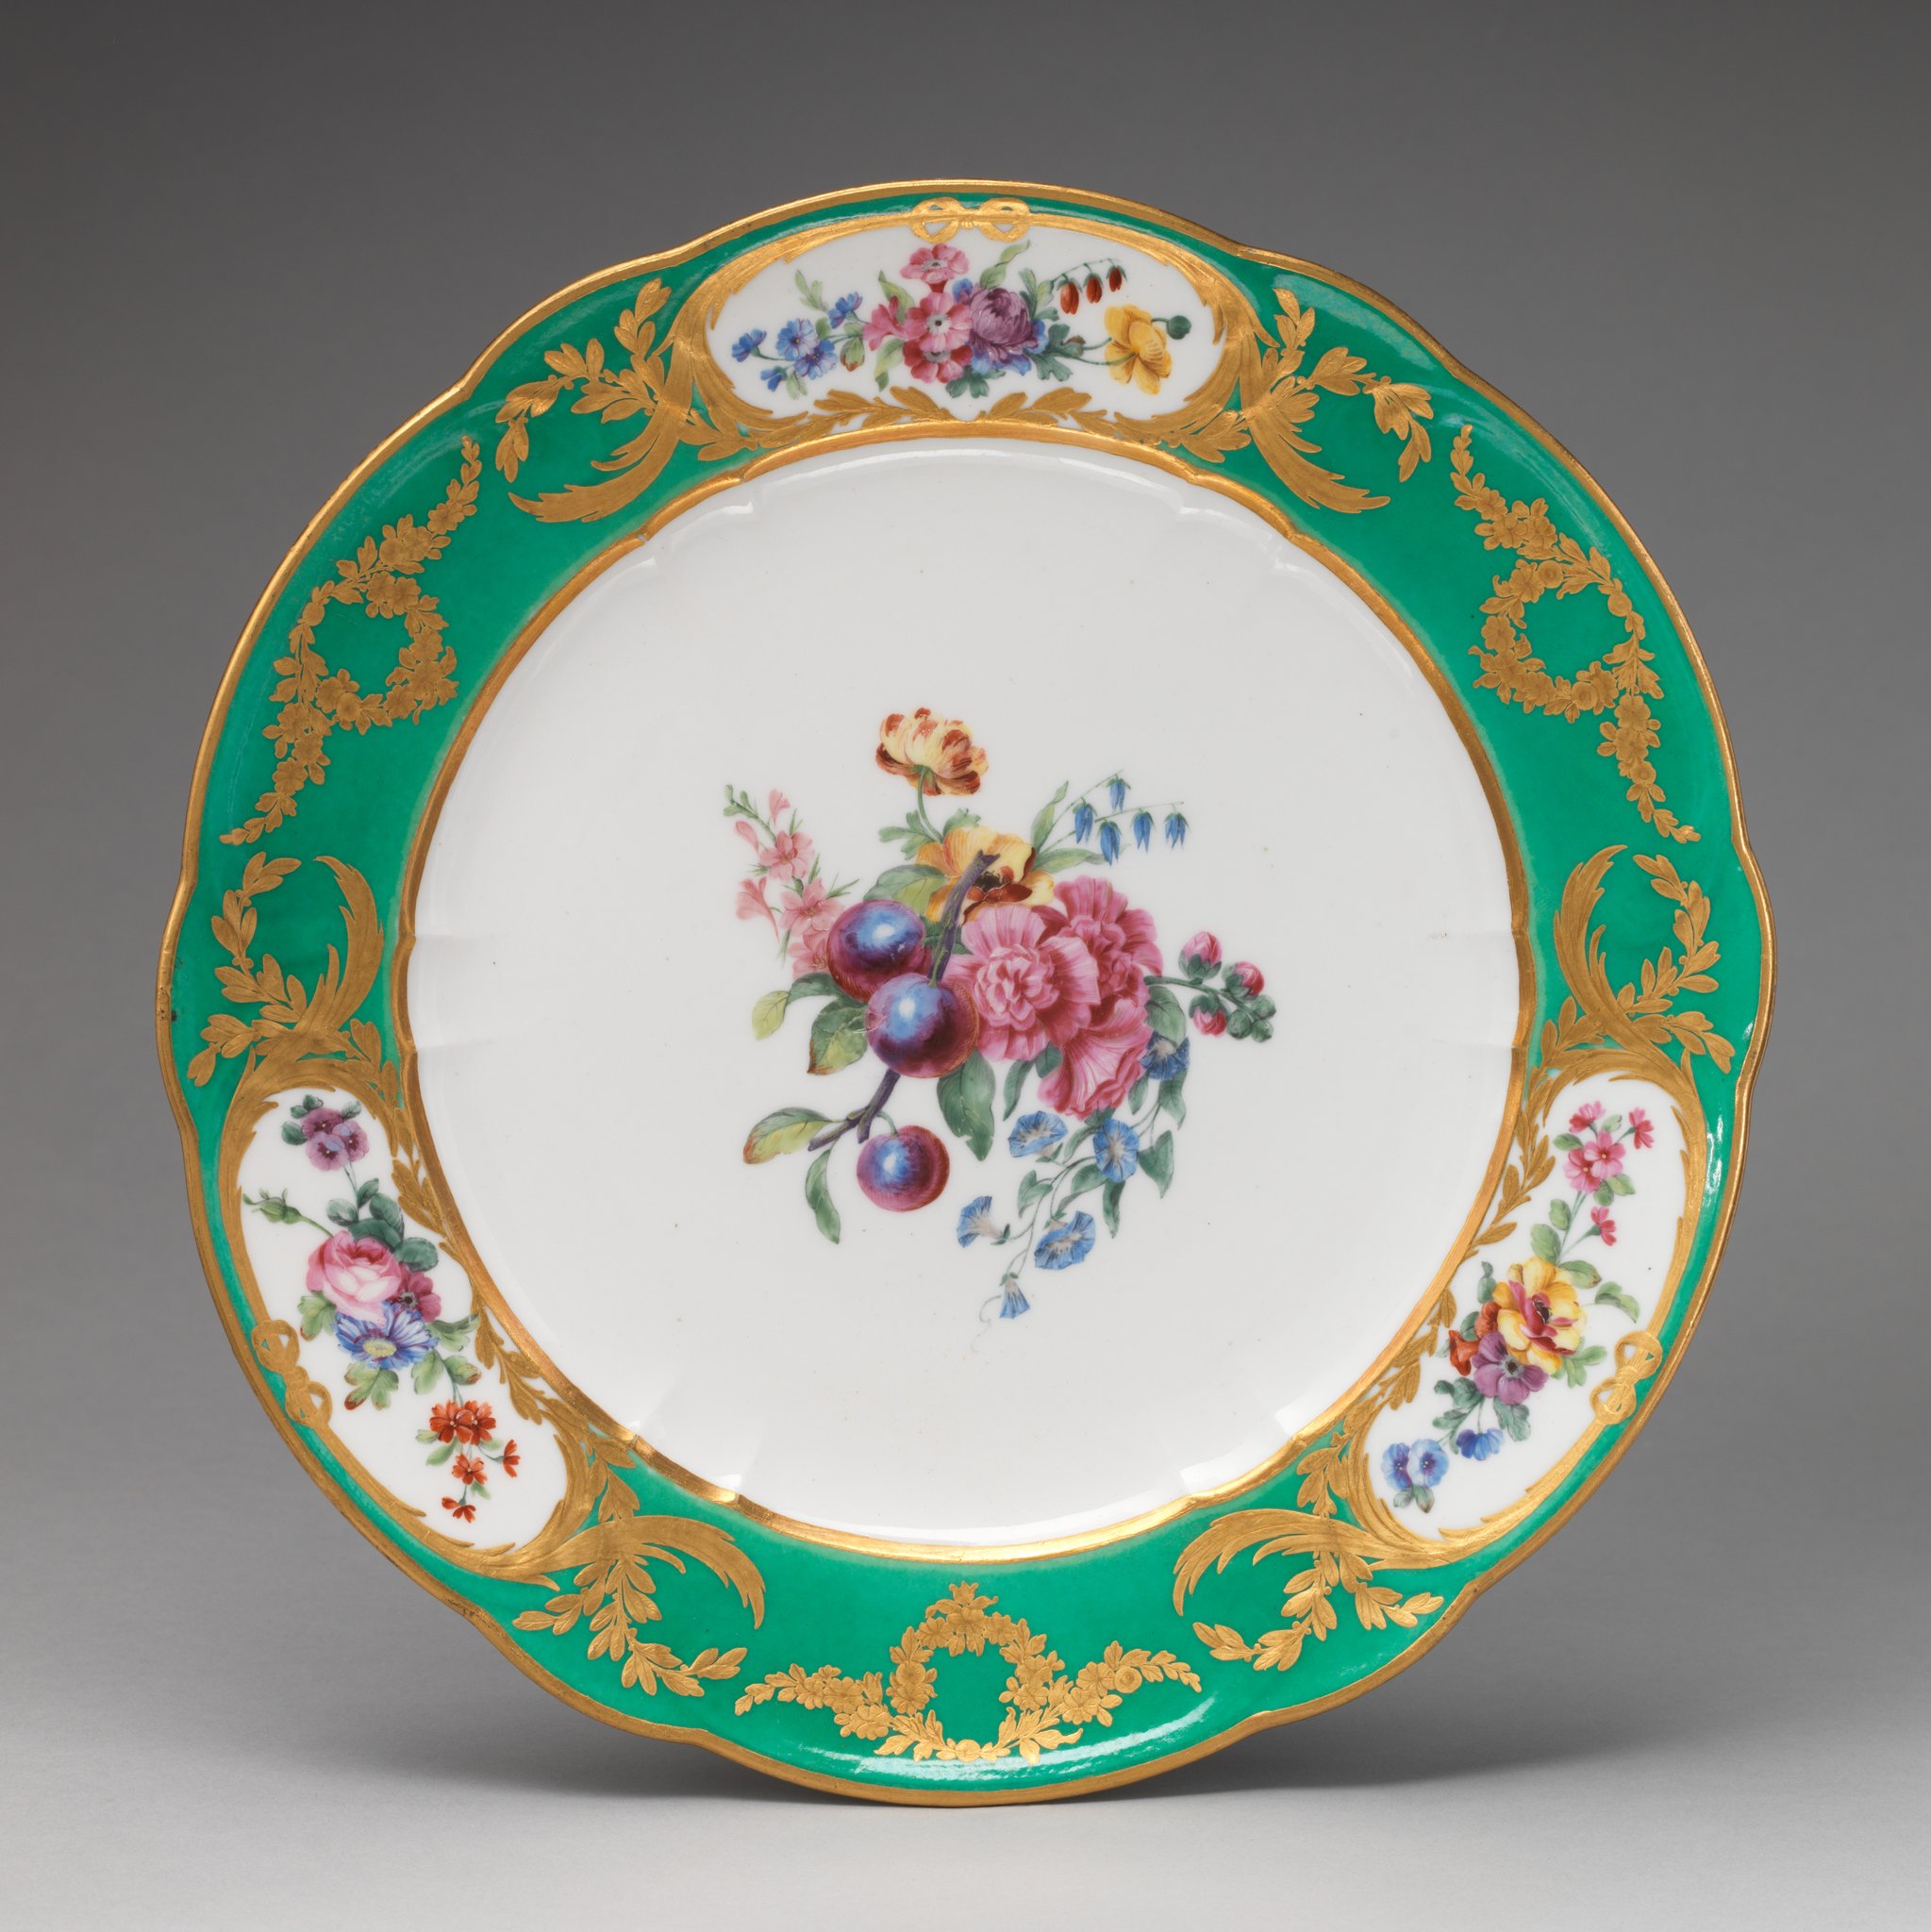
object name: plate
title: Plate (part of a service)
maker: sèvres manufactory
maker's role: manufactory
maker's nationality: french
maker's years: 1740-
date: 1777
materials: soft paste porcelain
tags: fruit,flowers